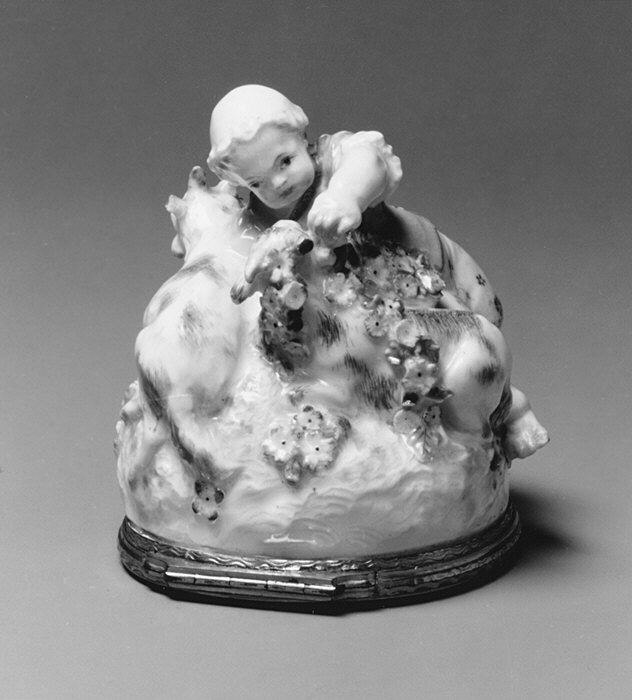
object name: snuffbox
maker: chelsea porcelain manufactory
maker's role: factory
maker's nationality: british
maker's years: 1744-1784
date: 1755-1760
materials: gilt, soft paste porcelain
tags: animals,children